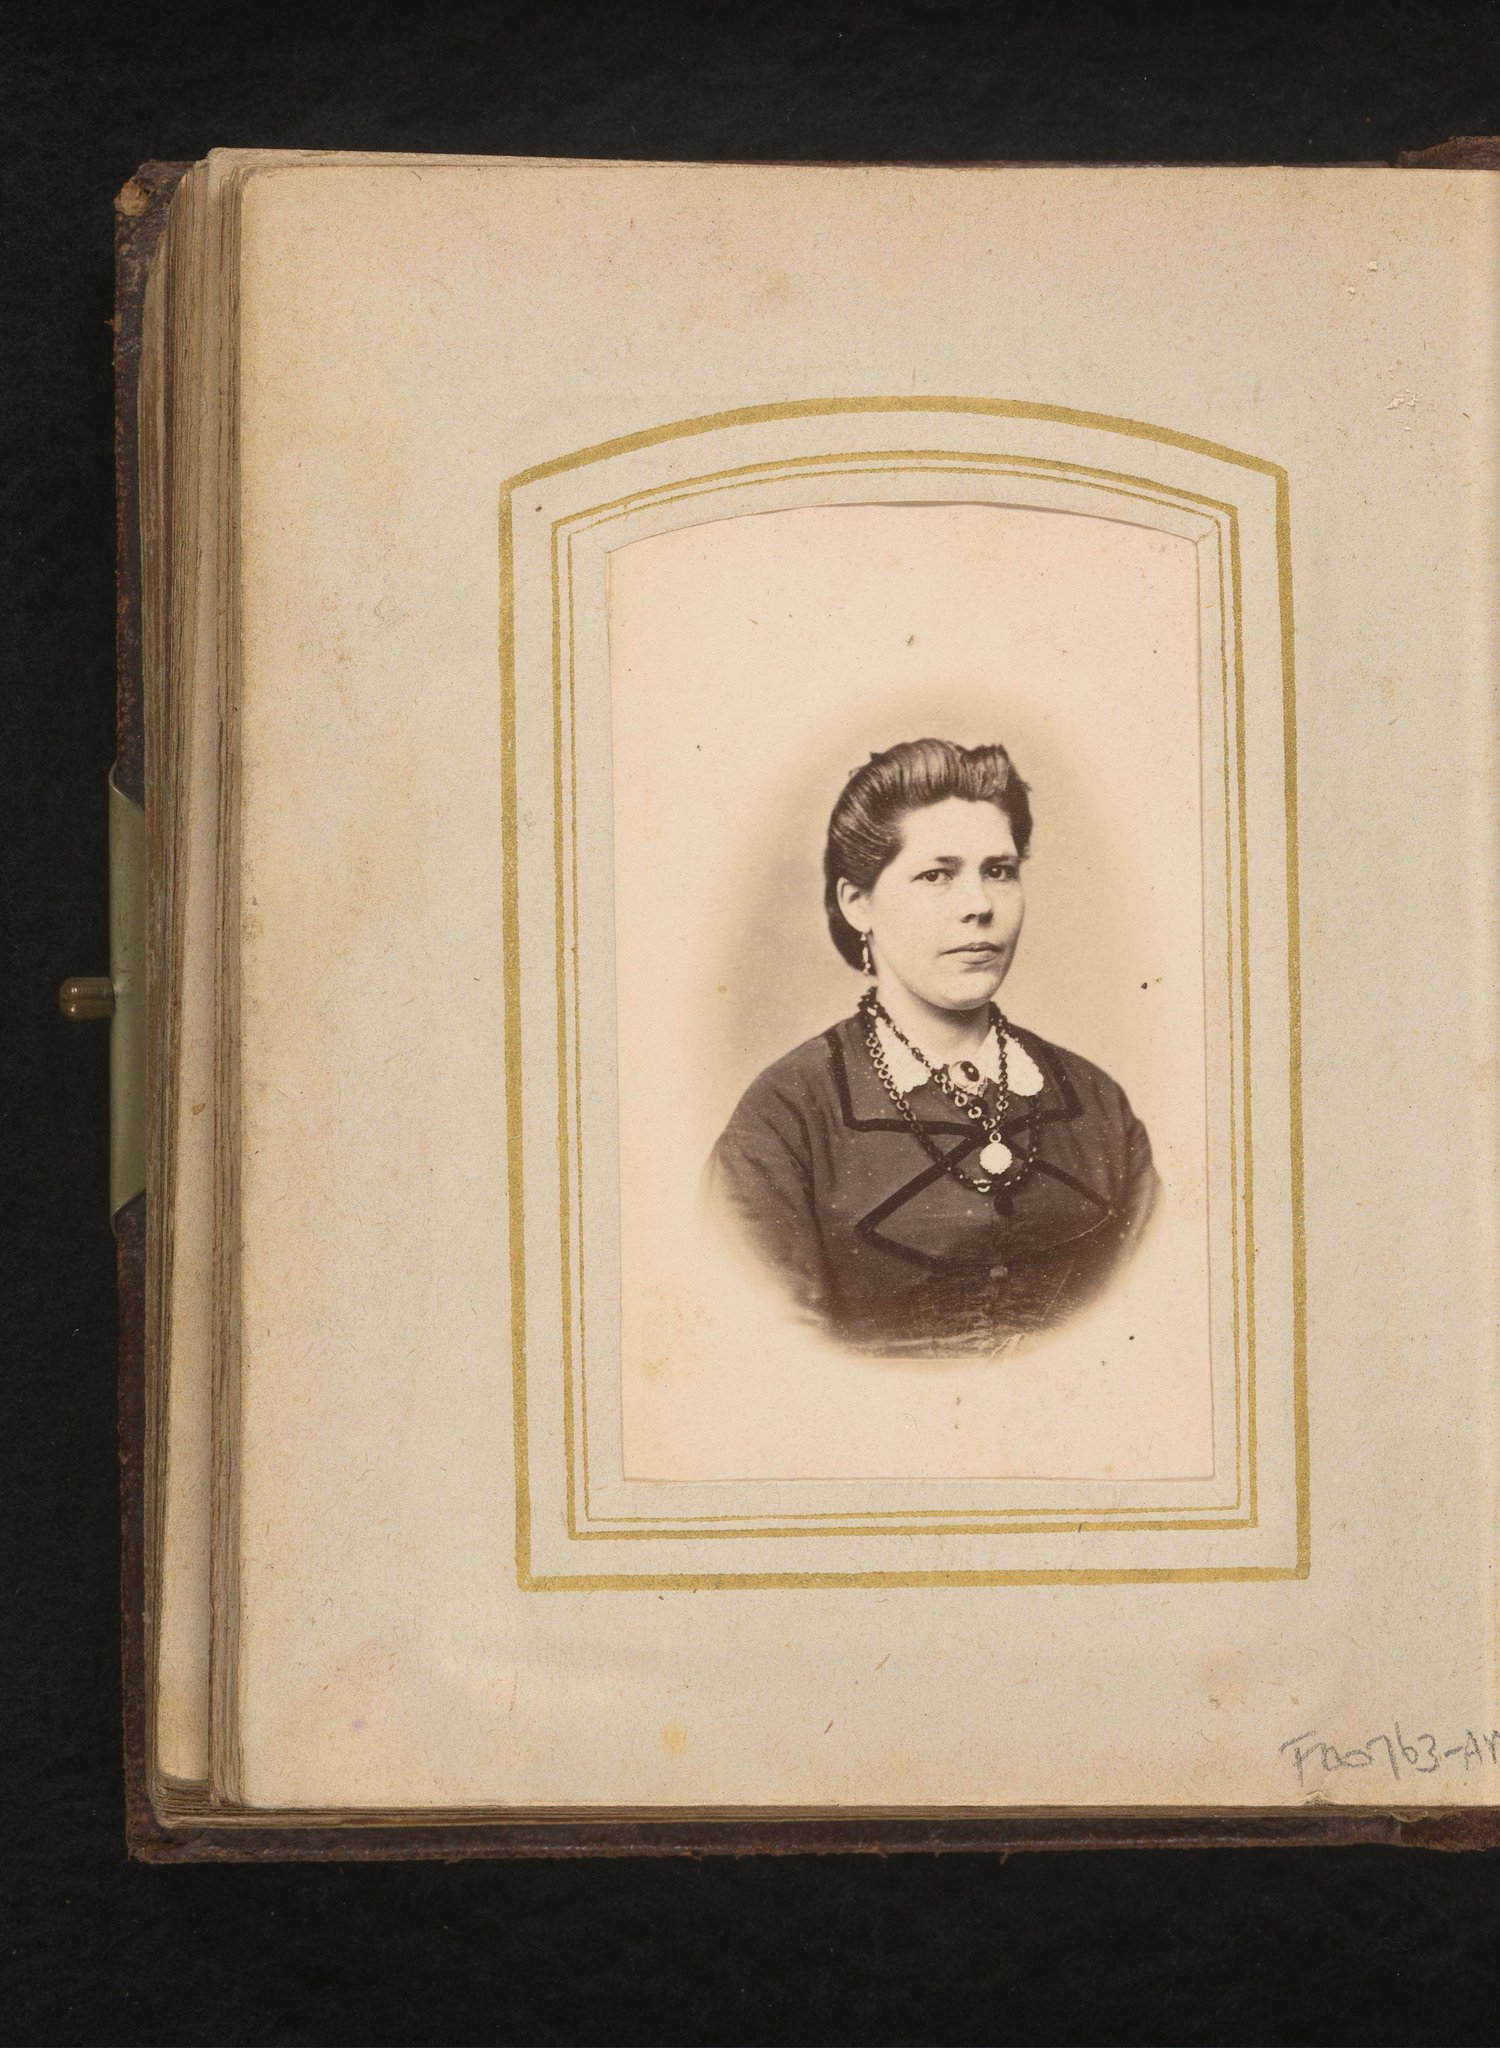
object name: photograph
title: Portret van een vrouw met halsketting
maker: willem gerhardus kuijer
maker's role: fotograaf, hoffotograaf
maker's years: 1834-1899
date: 1867-1880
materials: cardboard, photographic support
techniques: albumen print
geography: amsterdam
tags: historical persons - bb - woman, necklace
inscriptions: inscription: ‘Photographisch/ Atelier/ van/ W. G. Kuijer/ Rozengracht/ tusschen de 1e en 2e Bloemdwarsstraat/ DD. 455/ Amsterdam’